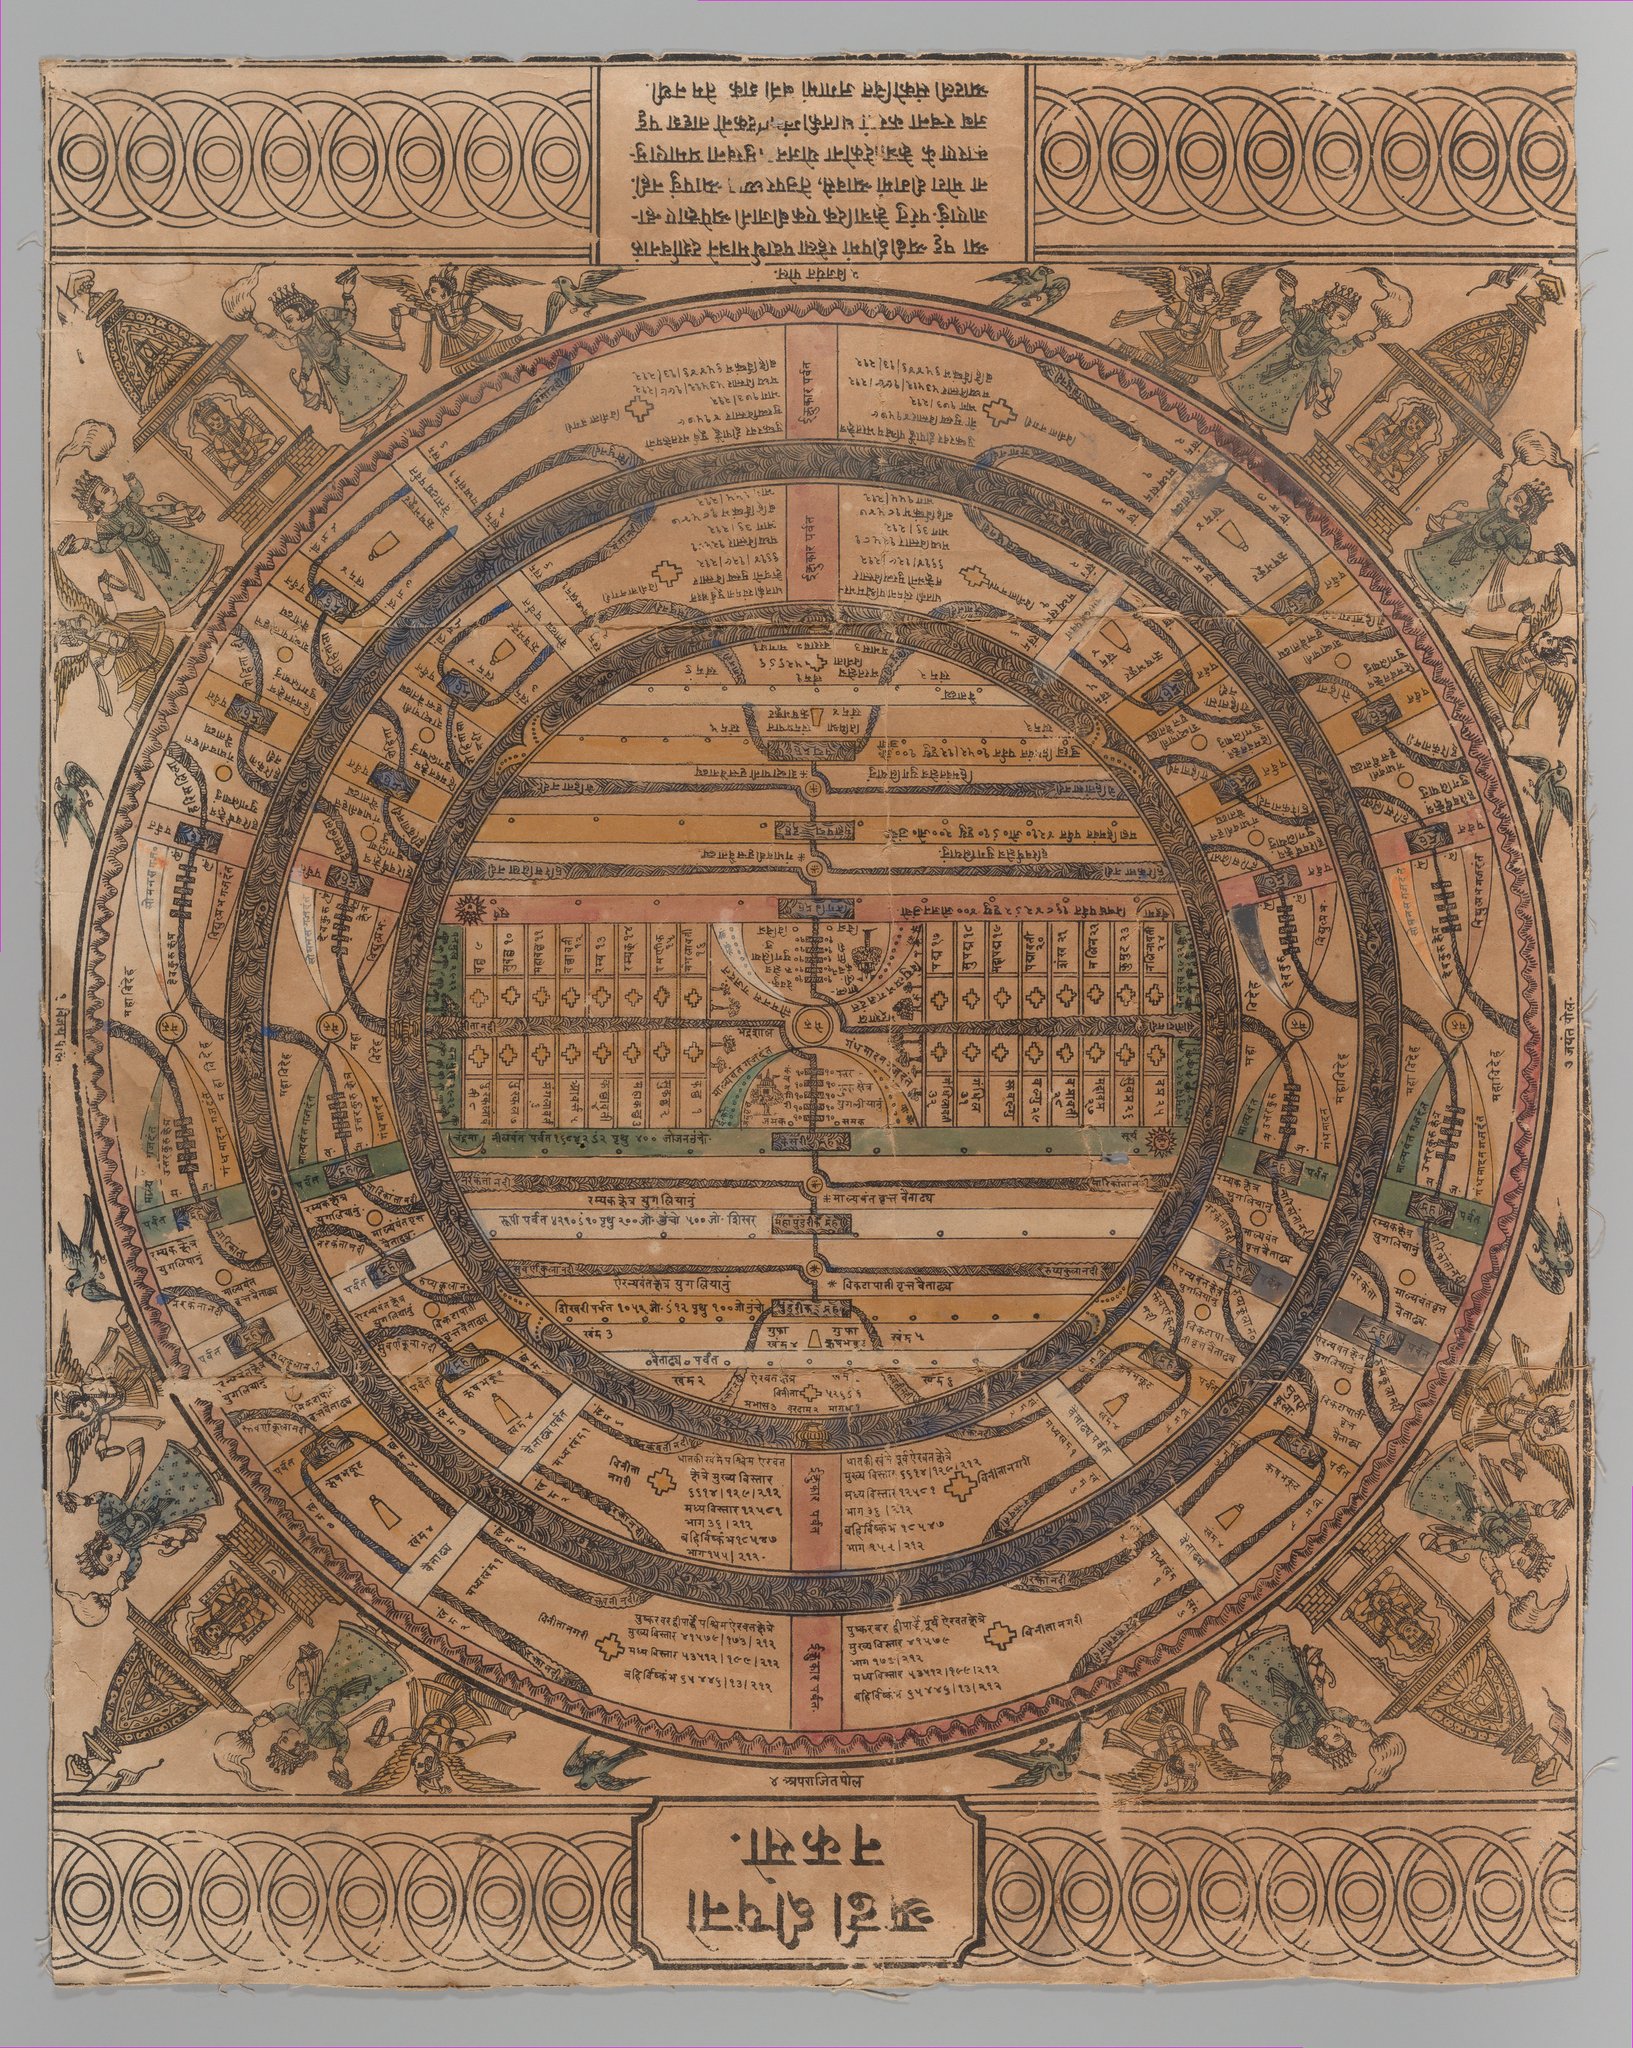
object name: lithograph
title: Jain cosmological map of adhaidvipa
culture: indian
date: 1900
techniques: lithograph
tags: maps